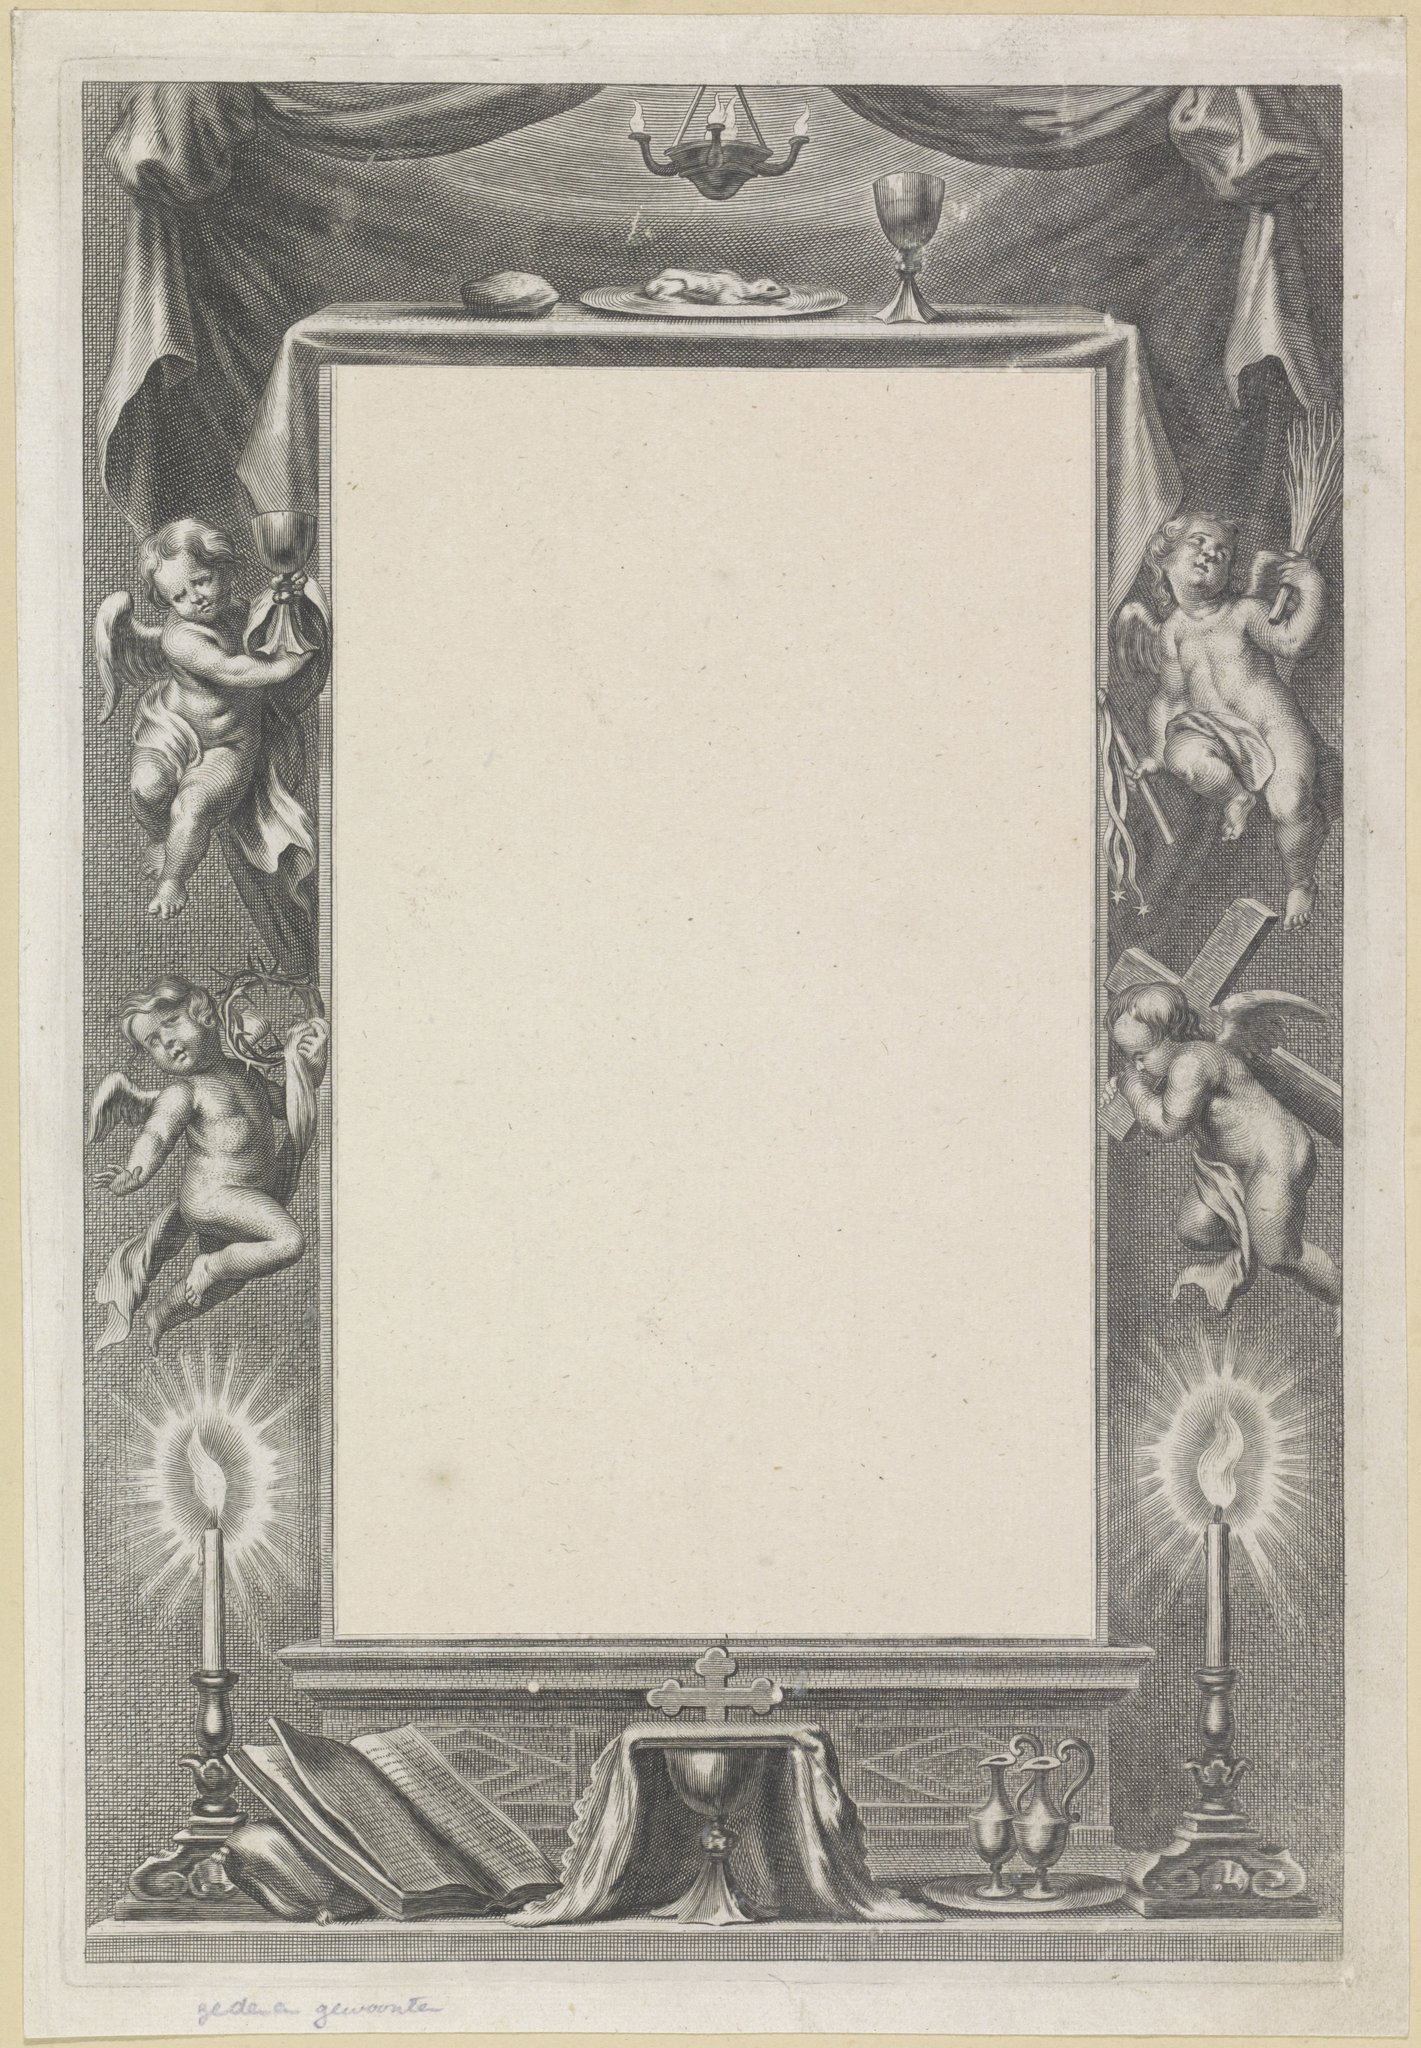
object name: print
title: Omlijsting met symbolen van de Passie en de Eucharistie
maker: Anonymous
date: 1650-1750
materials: paper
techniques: engraving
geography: southern netherlands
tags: 'pesah', passover ~ jewish religion, the eucharist ~ the fourth of the seven sacraments, single instruments of the passion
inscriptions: collector's mark: Lugt 2228, collector's mark: Lugt 240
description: Een omlijsting met links en rechts vier putti die de passiewerktuigen tonen: kelk, doornenkroon, roede en zweep en kruis. Midden boven het Pesachmaal: brood, wijn en een geslacht lam. Midden onder een altaar met daarop de attributen van de eucharistie en een opengeslagen Bijbel.